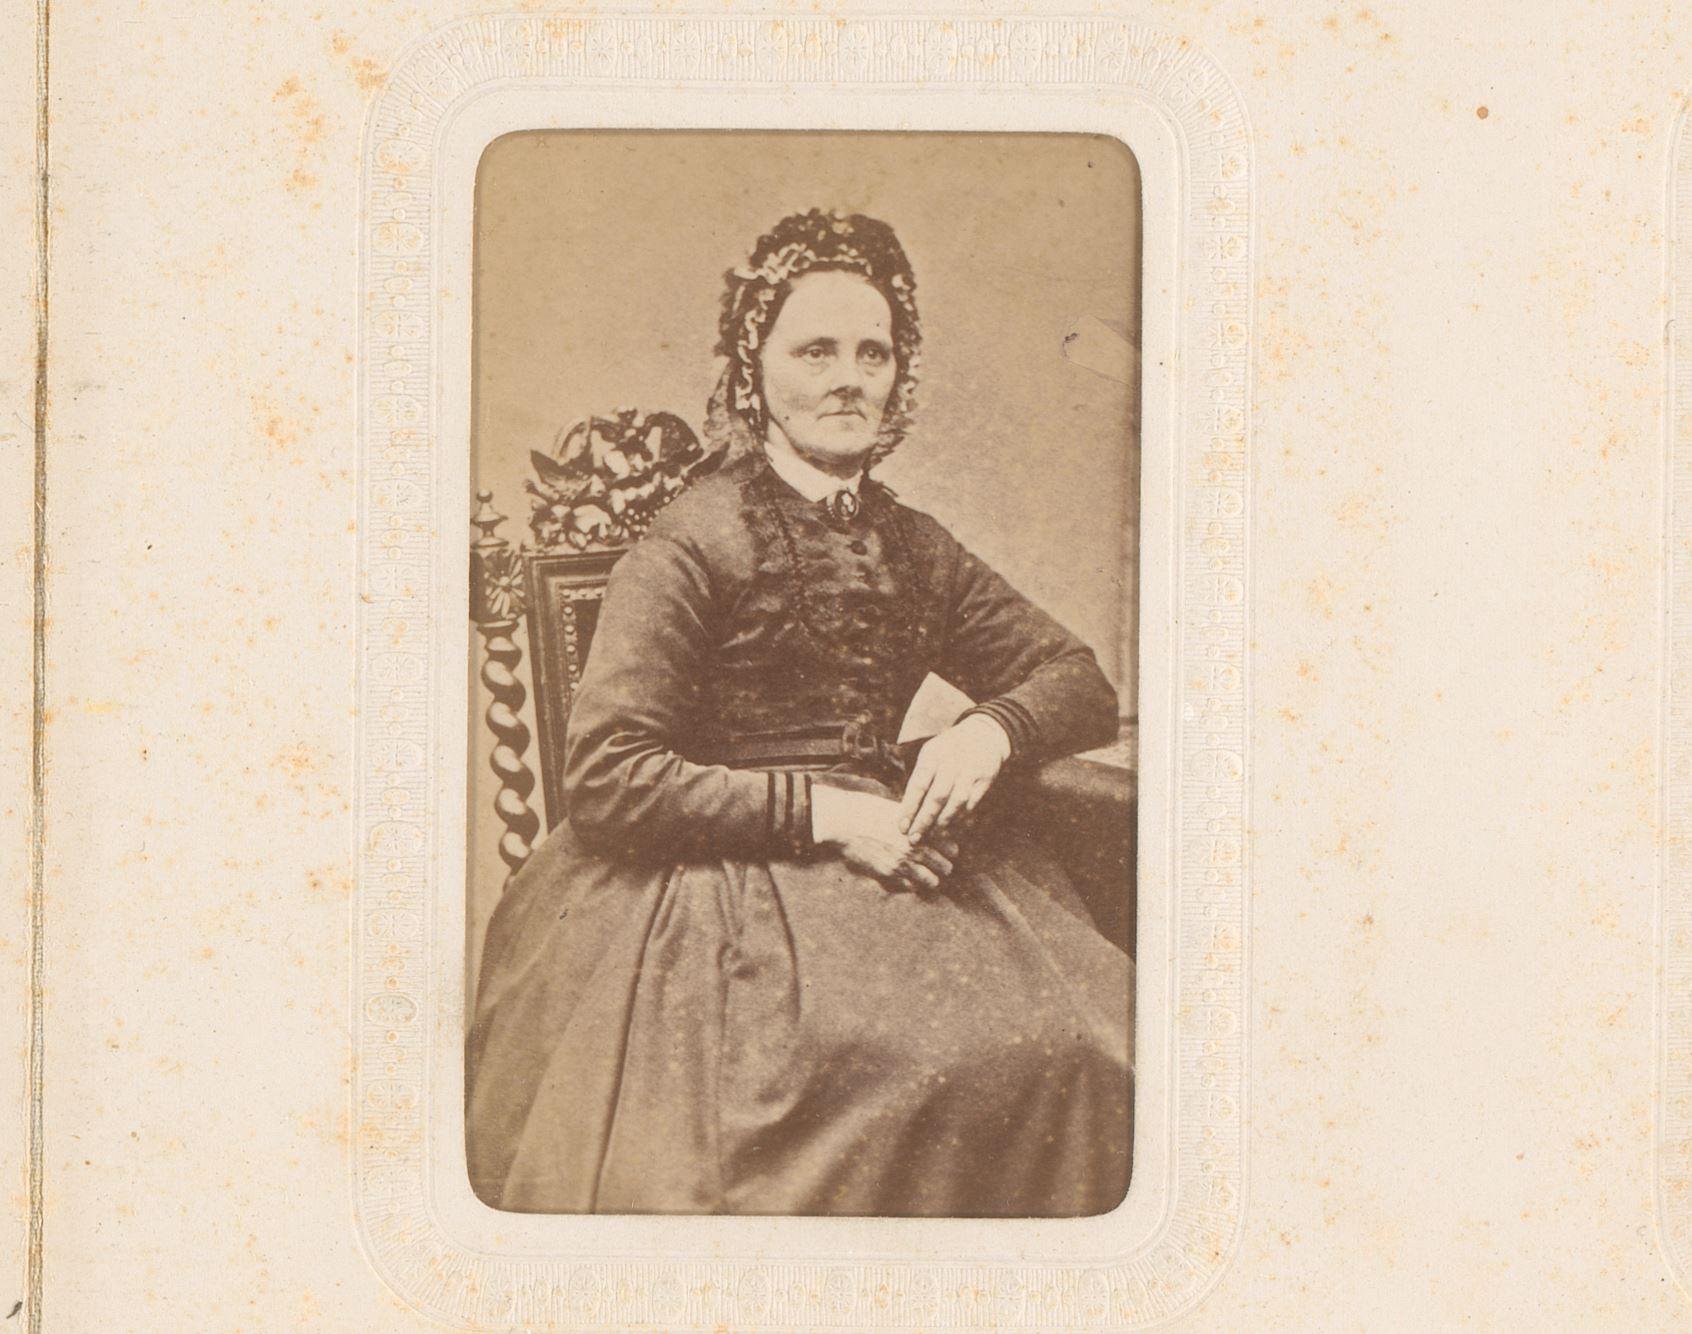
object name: photograph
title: Portret van een zittende vrouw met muts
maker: Anonymous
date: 1860-1900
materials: cardboard, photographic support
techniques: albumen print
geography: netherlands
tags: sitting figure - aa - female human figure, historical persons - bb - woman, head-gear: cap